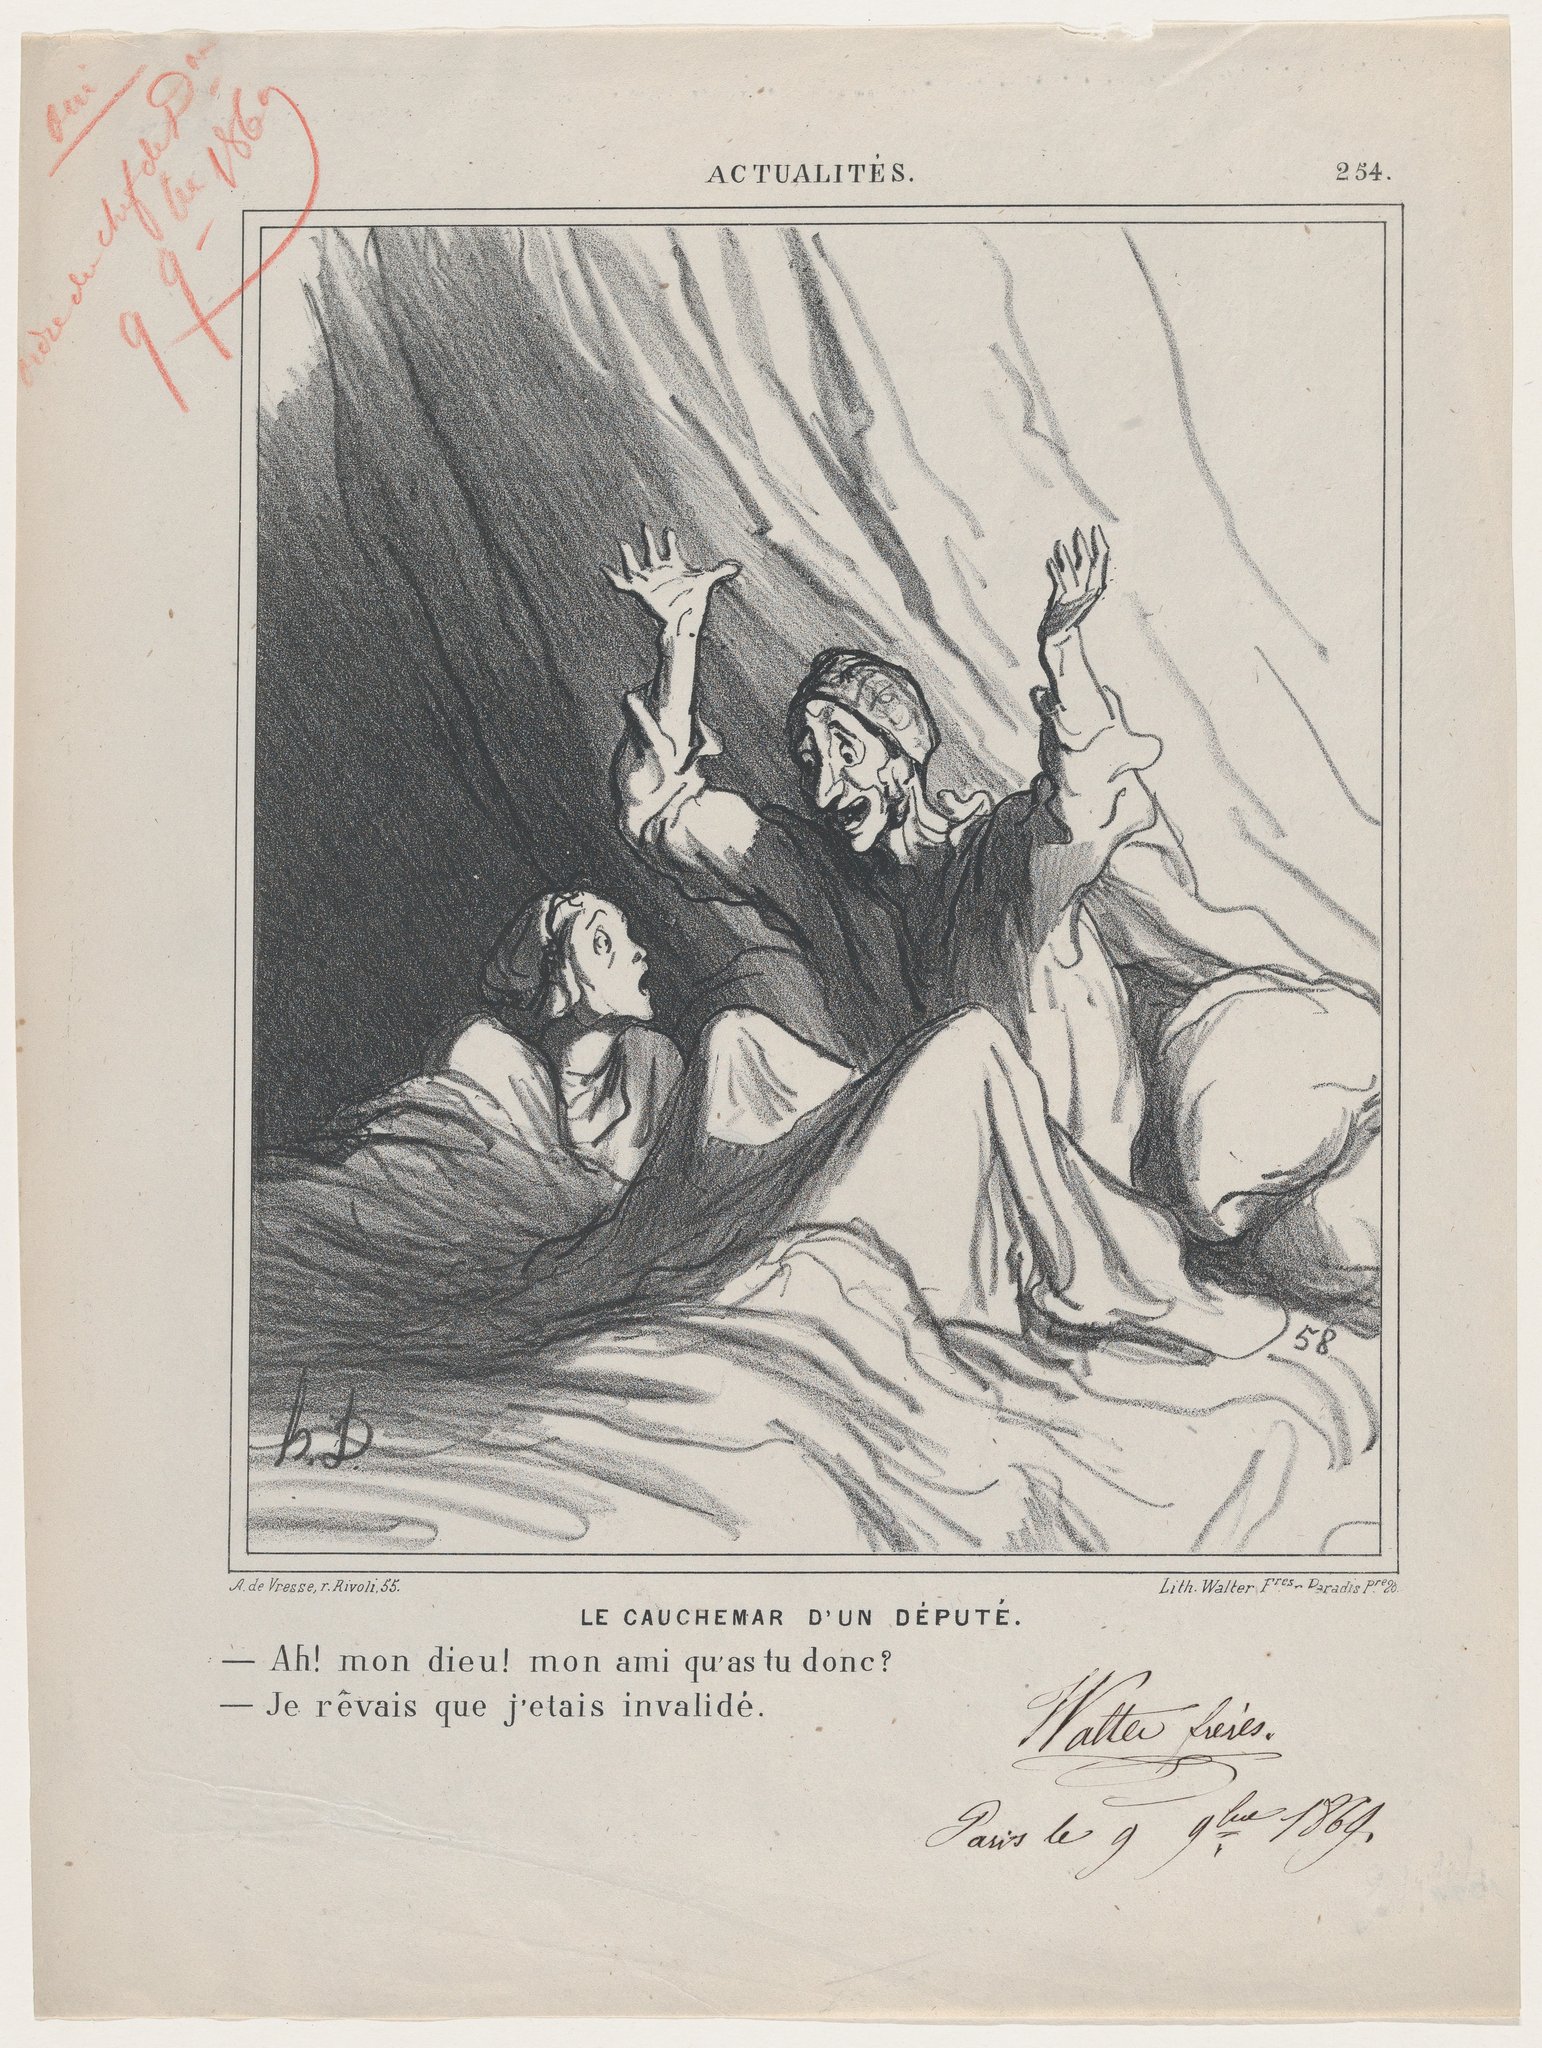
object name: print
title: A deputy's nightmare: –Oh my friend, what has happened? –I dreamed I was invalidated, from 'News of the day,' published in Le Charivari, December 7, 1869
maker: honoré daumier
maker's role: artist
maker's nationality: french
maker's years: 1808-1879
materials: paper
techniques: lithograph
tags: men,women